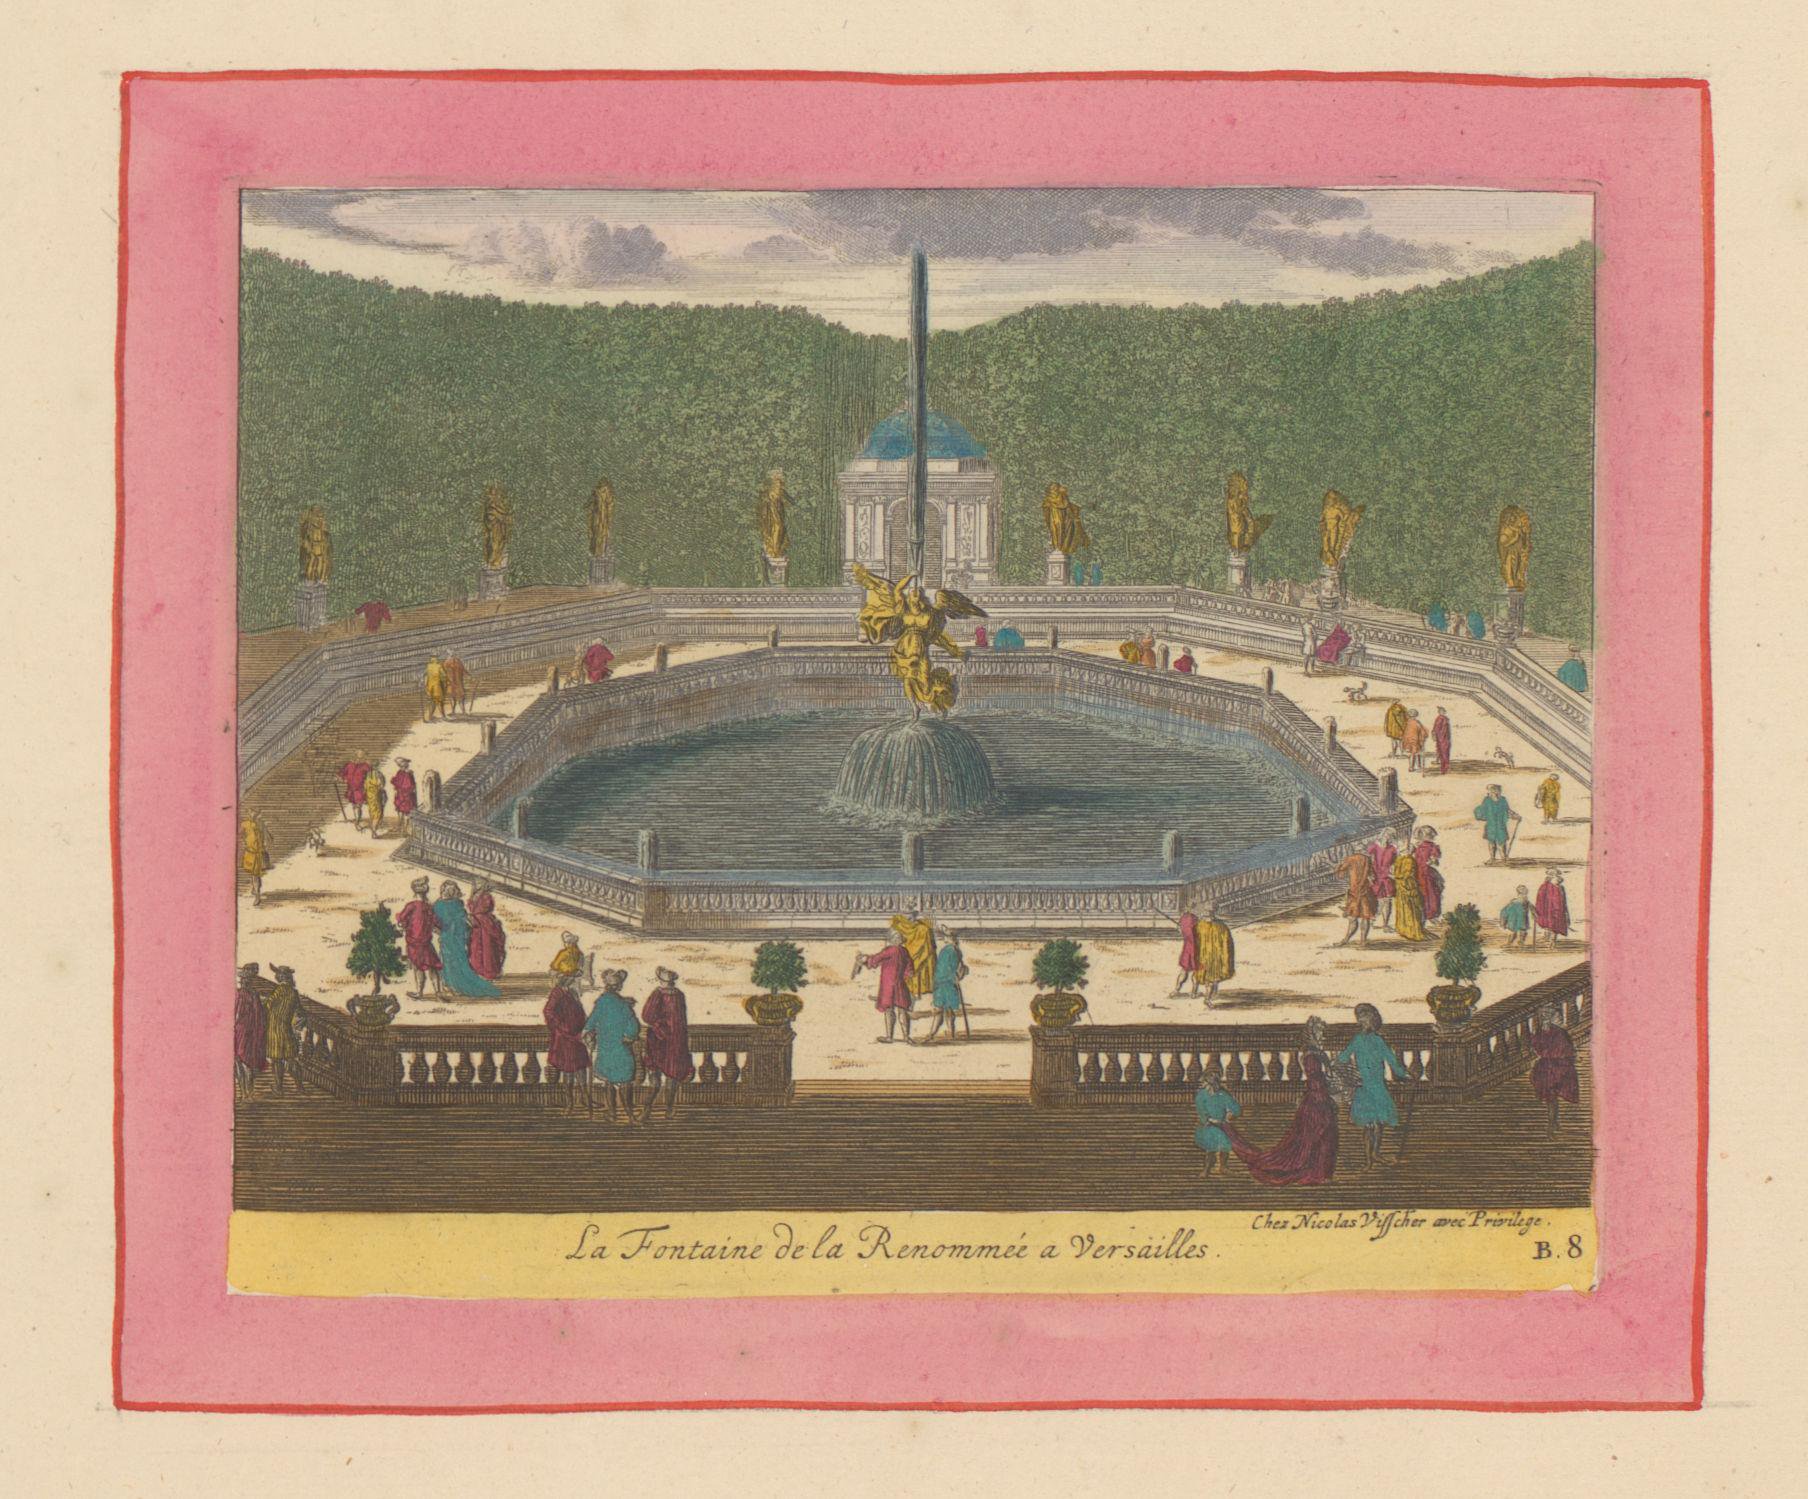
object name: album leaf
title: Veues de Versailles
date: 1686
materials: paper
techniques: etching, hand coloring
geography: amsterdam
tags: garden fountain, french or architectonic garden; formal garden, fame; 'fama', 'fama buona', 'fama chiara' (ripa)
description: Fontein van de Faam in het Bosquet de la Renommée, later Bosquet des Bains d’Apollon genoemd, te Versailles. Rechtsonder het serienummer: B8. Prent maakt deel uit van een album.